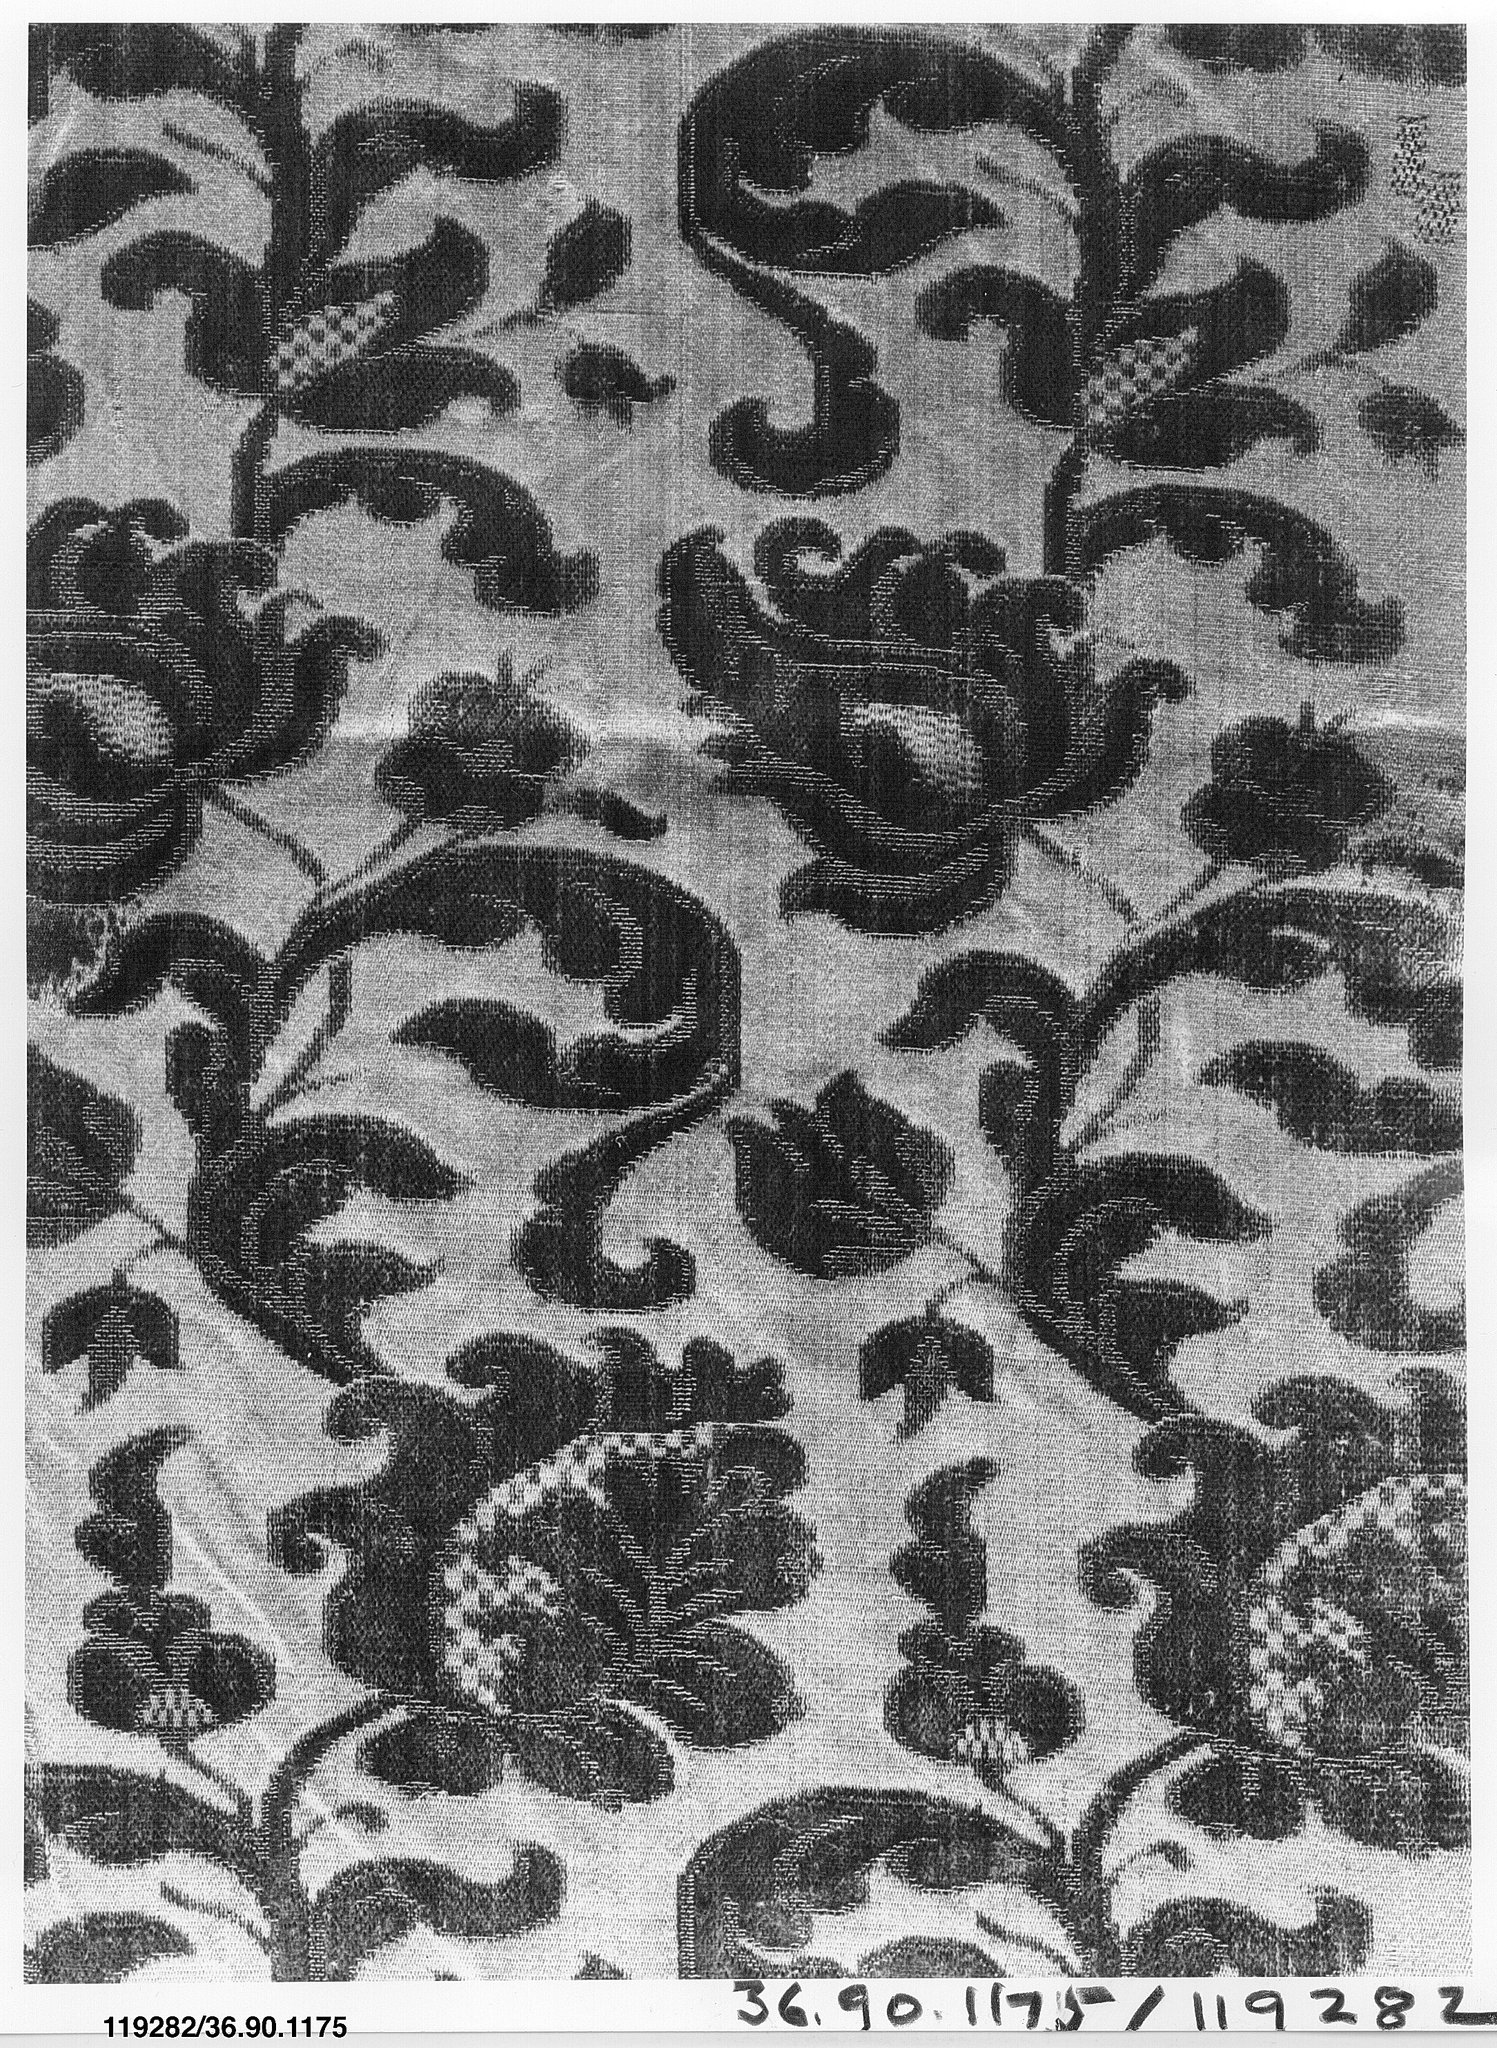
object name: piece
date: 1701-1733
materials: silk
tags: flowers,leaves